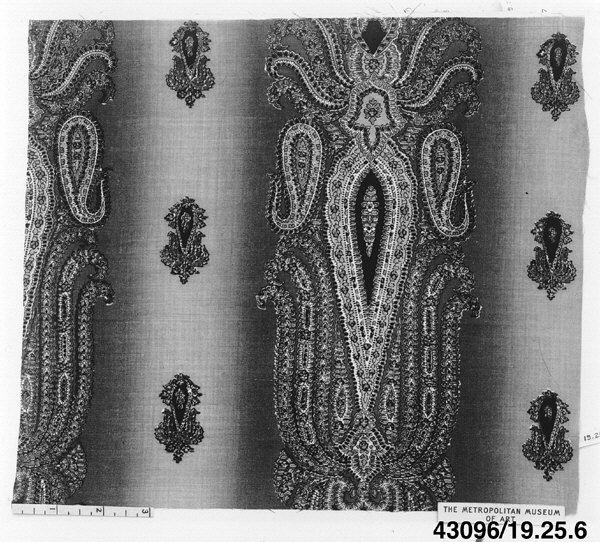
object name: sample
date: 1830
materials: wool